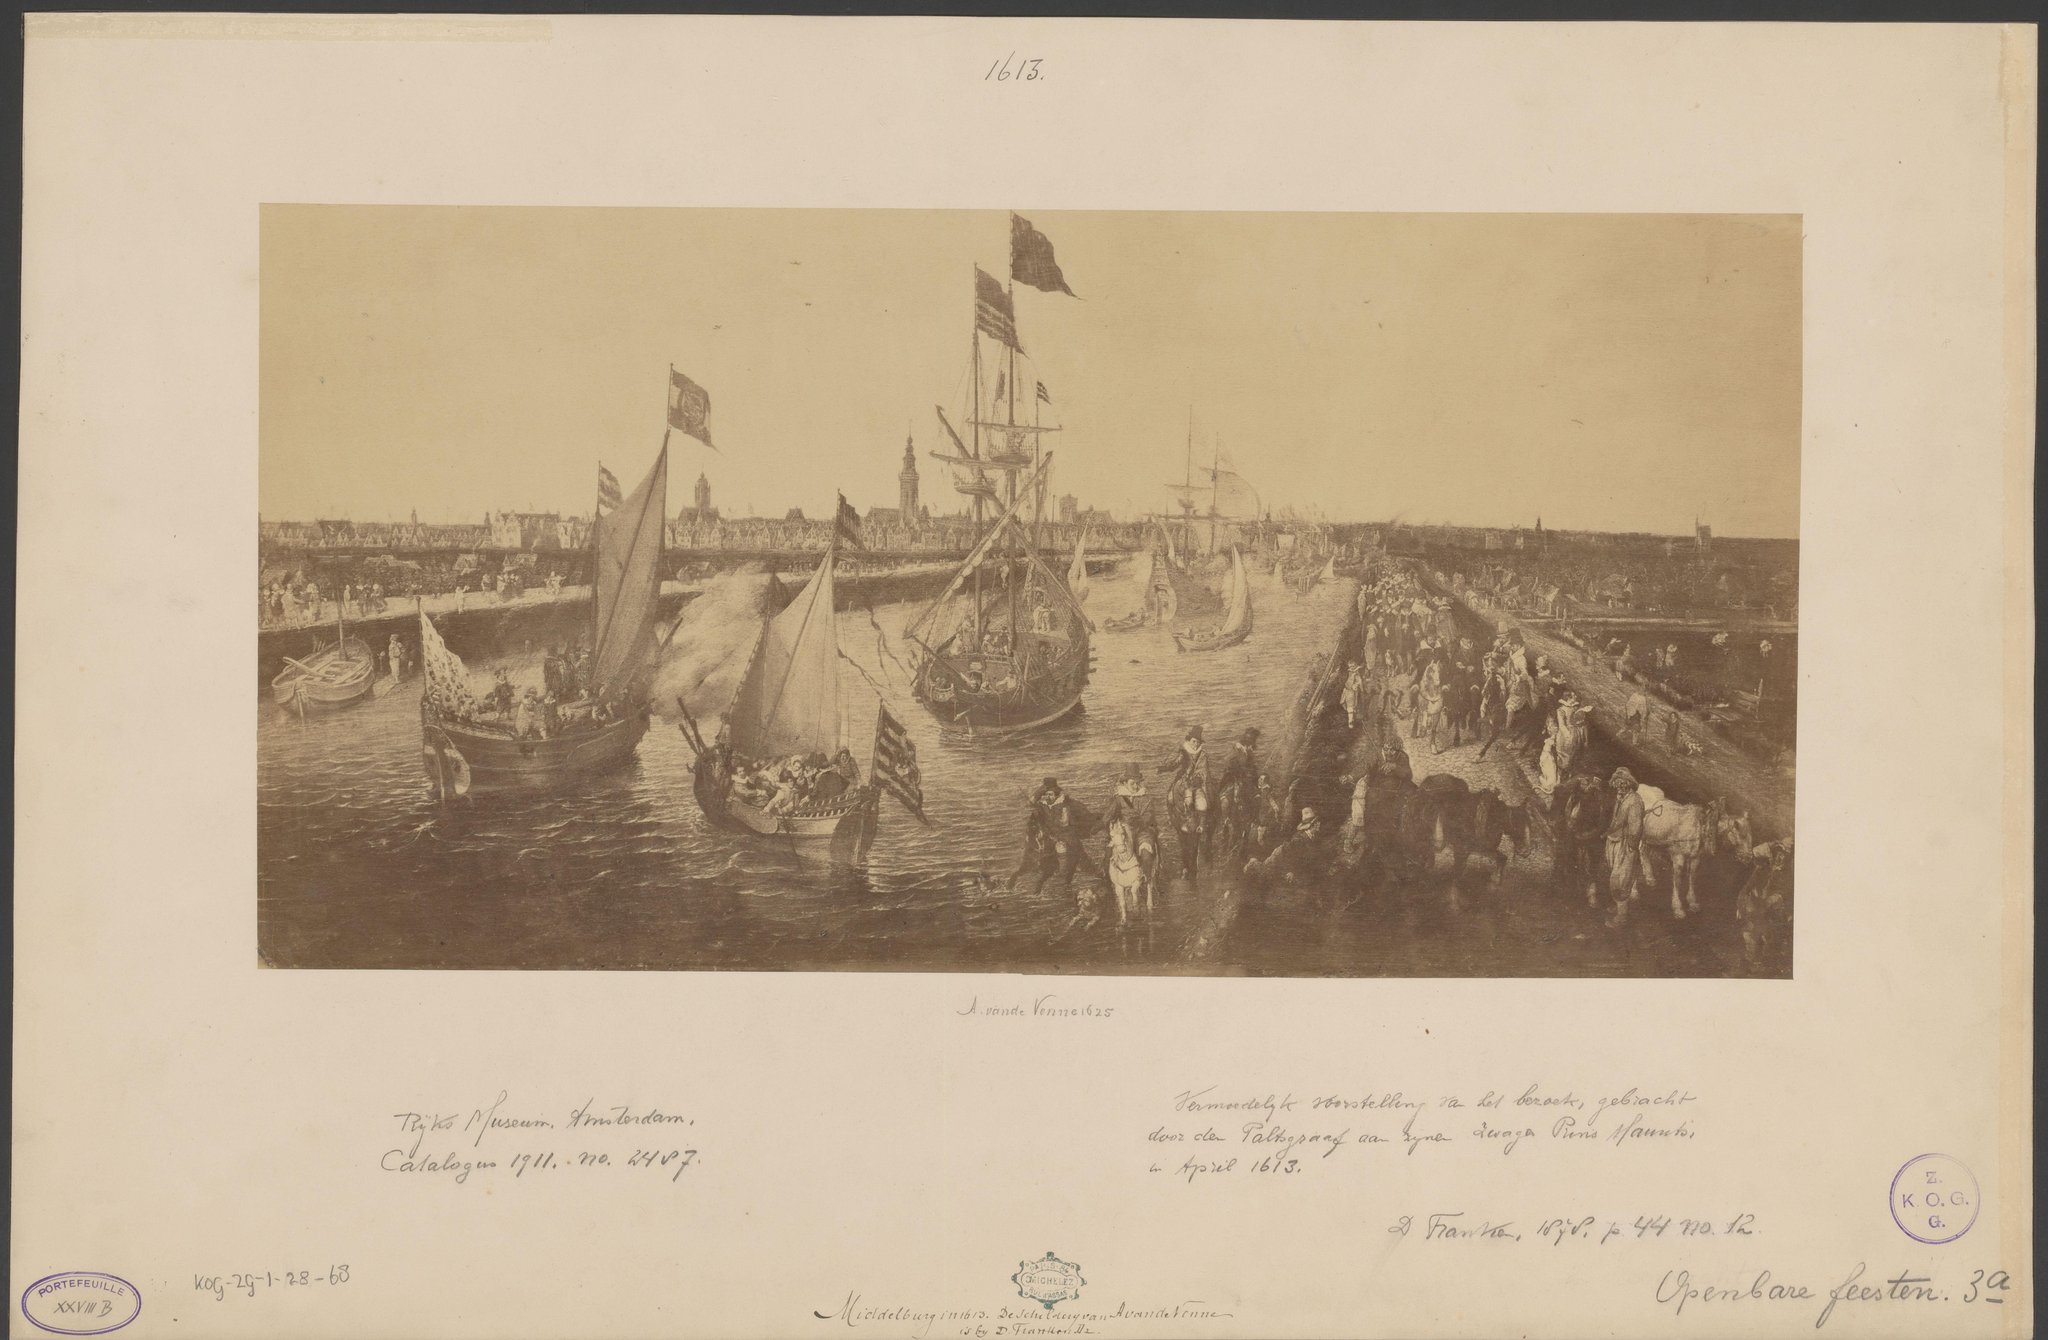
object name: photograph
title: Vertrek van een hoogwaardigheidsbekleder uit Middelburg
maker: Anonymous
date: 1875-1930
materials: cardboard, paper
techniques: albumen print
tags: the hague, maurice (prince of orange), sailing-ship, sailing-boat, city-view in general; 'veduta', canal, middelburg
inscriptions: collector's mark: Lugt 1641, stamp, stamp: ‘CMichellez Paris 84 Rue d'Assas’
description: Het vertrek van een hoogwaardigheidsbekleder uit Middelburg, 1615. Het oorlogsschip De Zeehondt wordt door paarden door het kanaal naar het havenhoofd getrokken. Rechts op de dijk rijdt de hoogwaardigheidsbekleder met een escorte te paard. Op het water eveneens de jacht van prins Maurits. In de verte het profiel van de stad Middelburg. Onderwerpsrubrieken binnen de Atlas Zeden en Gewoonten: Zeden en Gewoonten in Engeren Zin. Volksleven. Openbare feesten. Vorstelijke intochten, (Illuminaties, vuurwerken en dergelijke, openbare feesten).